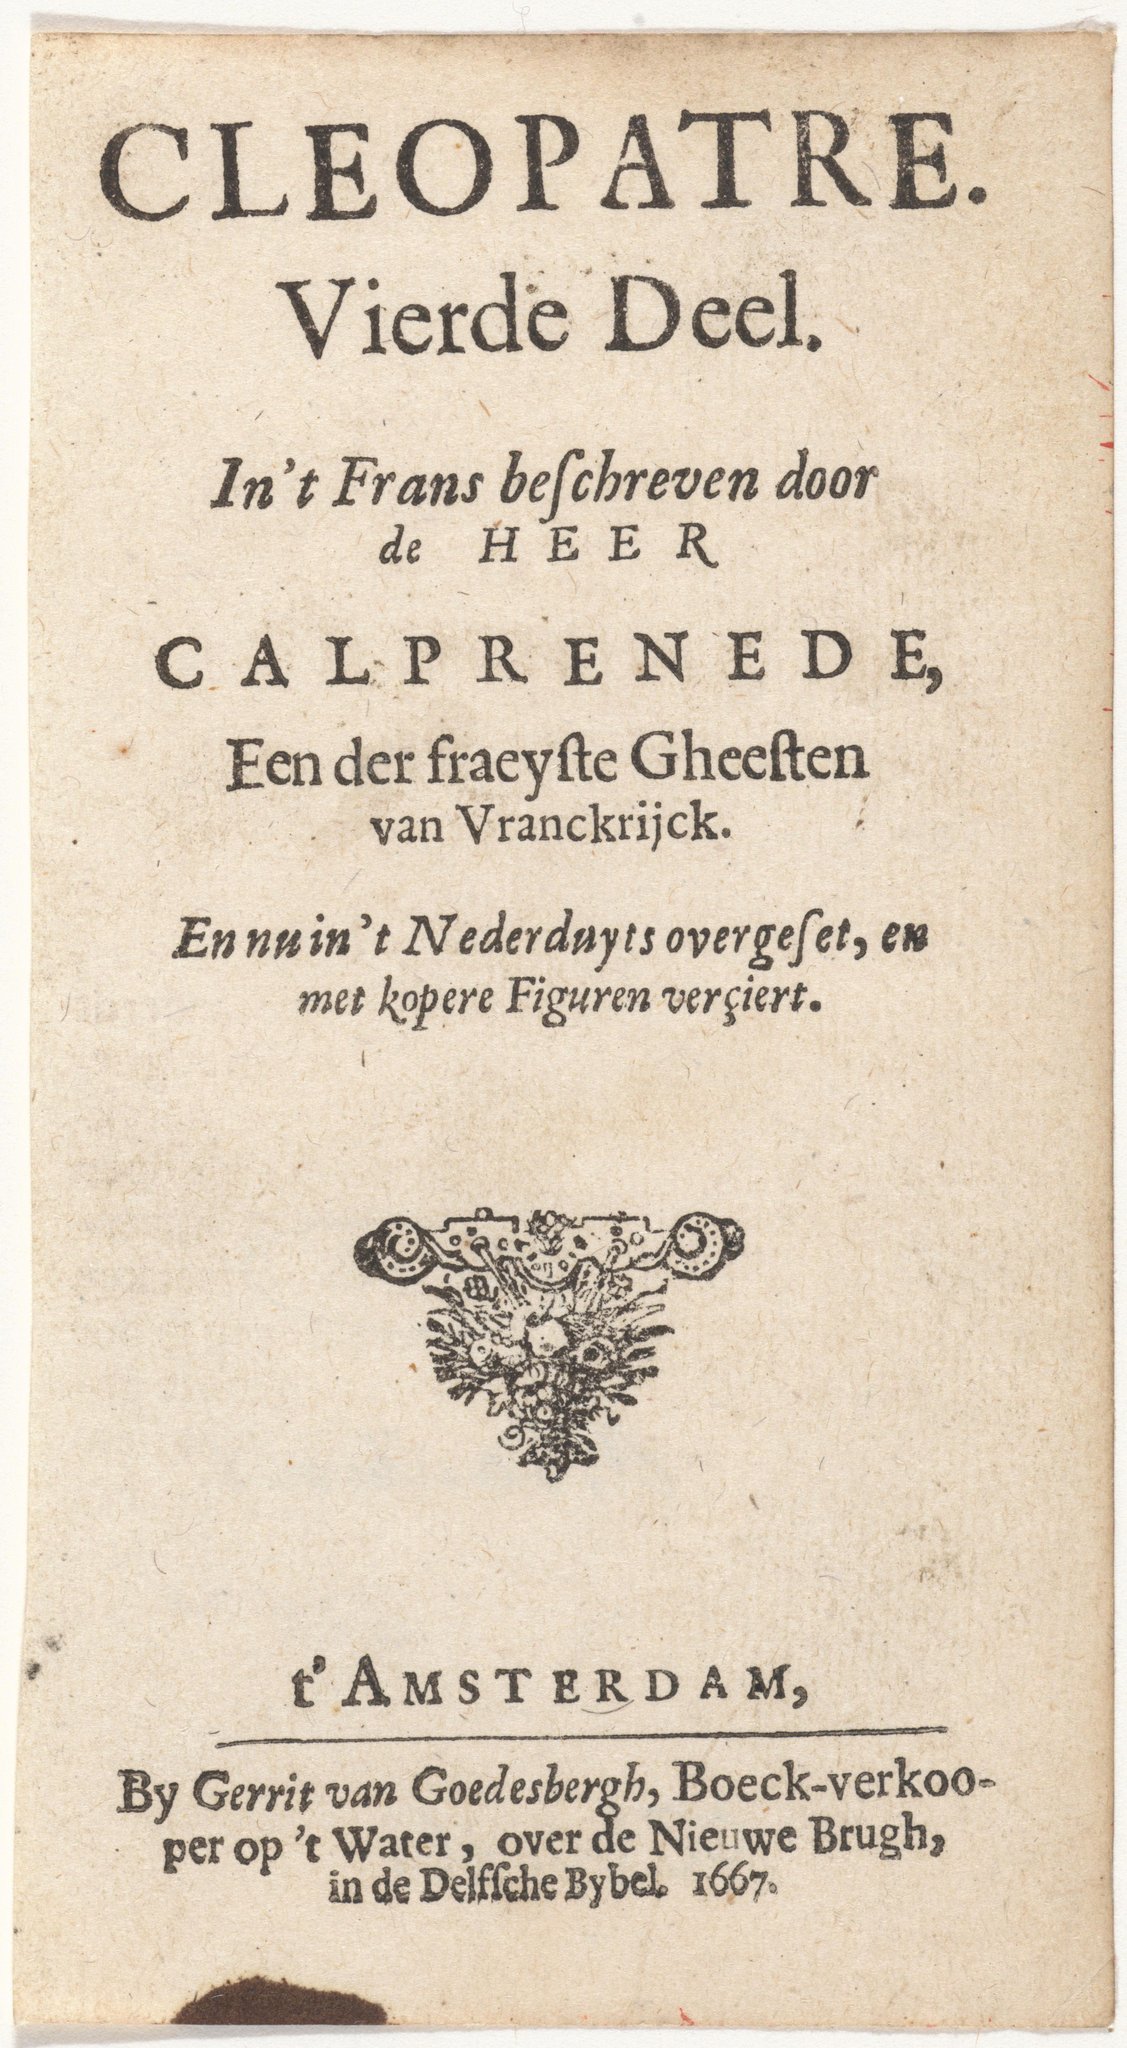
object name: text sheet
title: Titelpagina voor: Calprenède, La. Cleopatre. Vierde deel (...), 1667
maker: gerrit van goedesberg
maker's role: publisher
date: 1667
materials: paper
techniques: letterpress printing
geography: amsterdam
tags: floral interlace ~ ornament, title-page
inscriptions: collector's mark: Lugt 2228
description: Titelpagina voor: Calprenède, La. Cleopatre. Vierde deel..., Amsterdam: Gerrit van Goedesberg, 1667